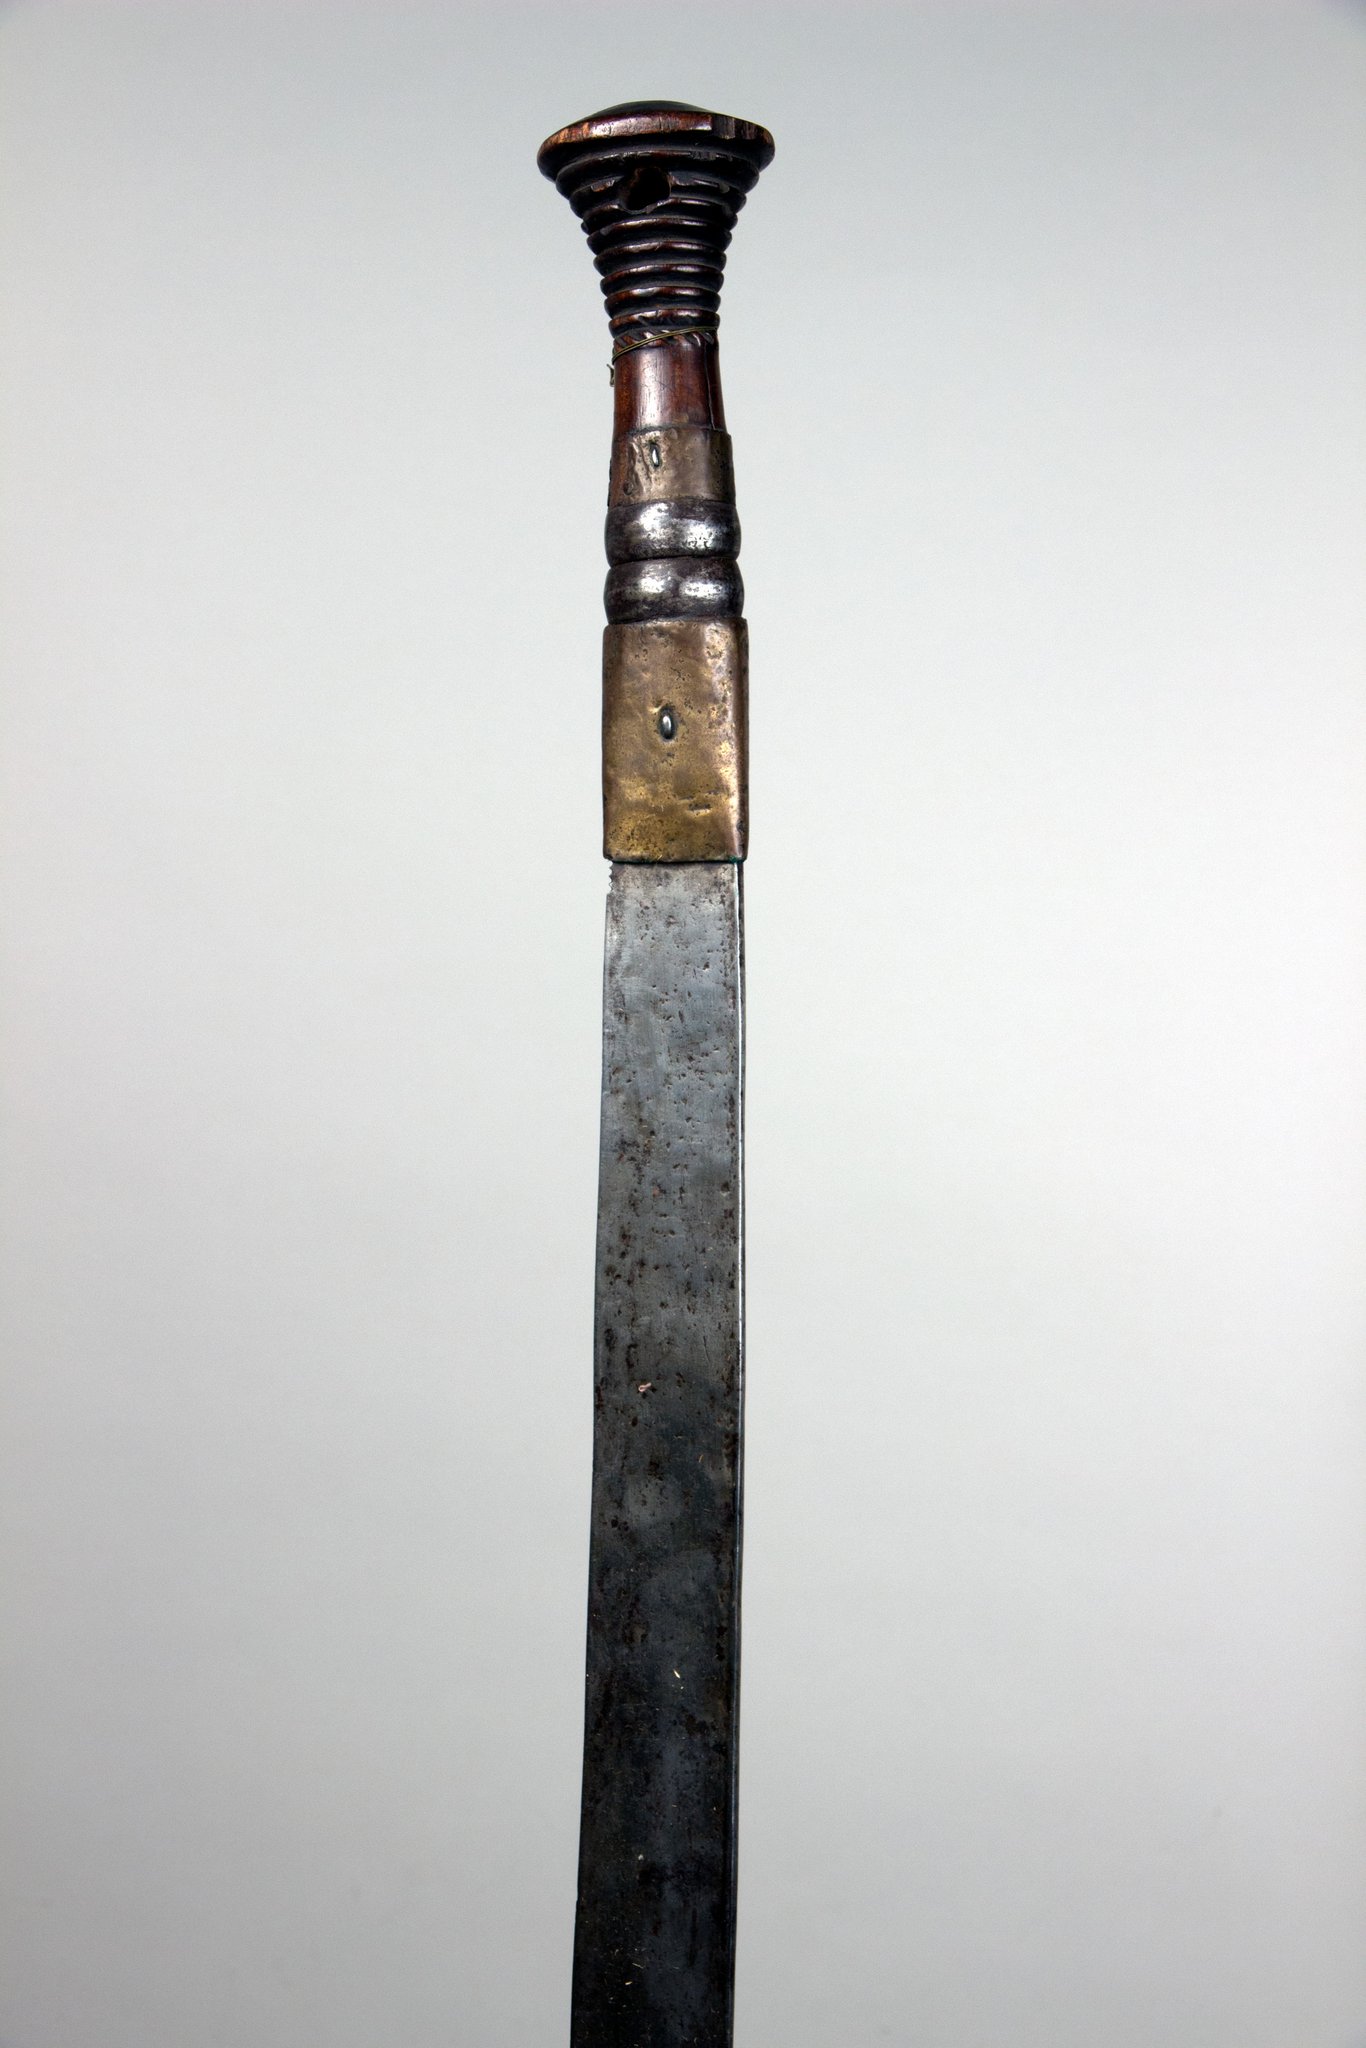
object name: sword dha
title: Sword (Dha)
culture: burmese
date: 1801-1900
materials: brass, wood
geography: myanmar